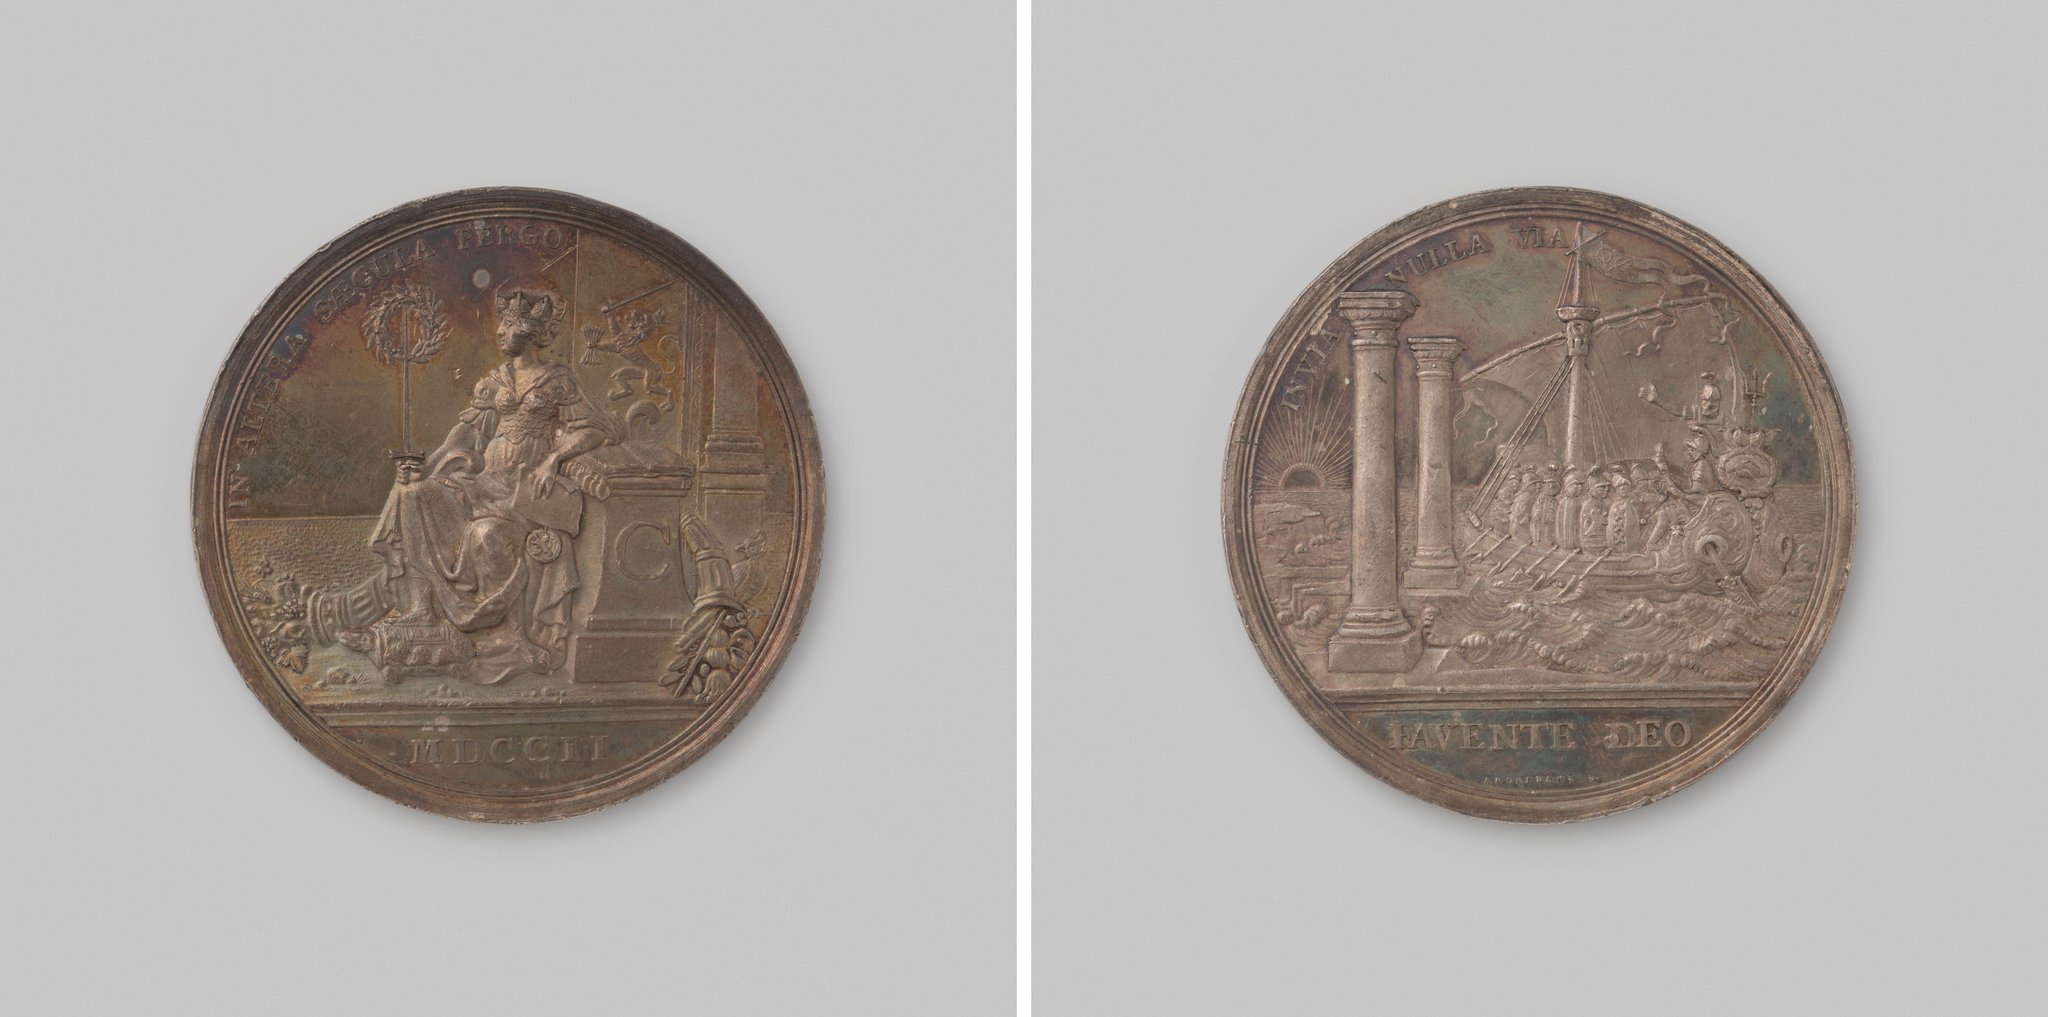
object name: history medal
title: Honderdjarig bestaan van de Verenigde Oostindische Compagnie 1702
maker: reynier arondeaux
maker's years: 1678-1727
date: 1702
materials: silver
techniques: striking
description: Zilveren penning, op de voorzijde de verpersoonlijkte Compagnie zittend naar links, met gezegelde oorkonde en zwaard met krans, de rechtervoet op een schildpad, leunend tegen een altaar met bijbel, te midden van hoorns des overvloeds en op de achtergrond de oceaan, met omschrift, in afsnede MDCCII, op de keerzijde een schip, bemand met soldaten met schilden waarop de wapens van de VOC-Kamers, varend op zee, langs de Zuilen van Hercules, de zon tegemoet, met omschrift en afsnedetekst.